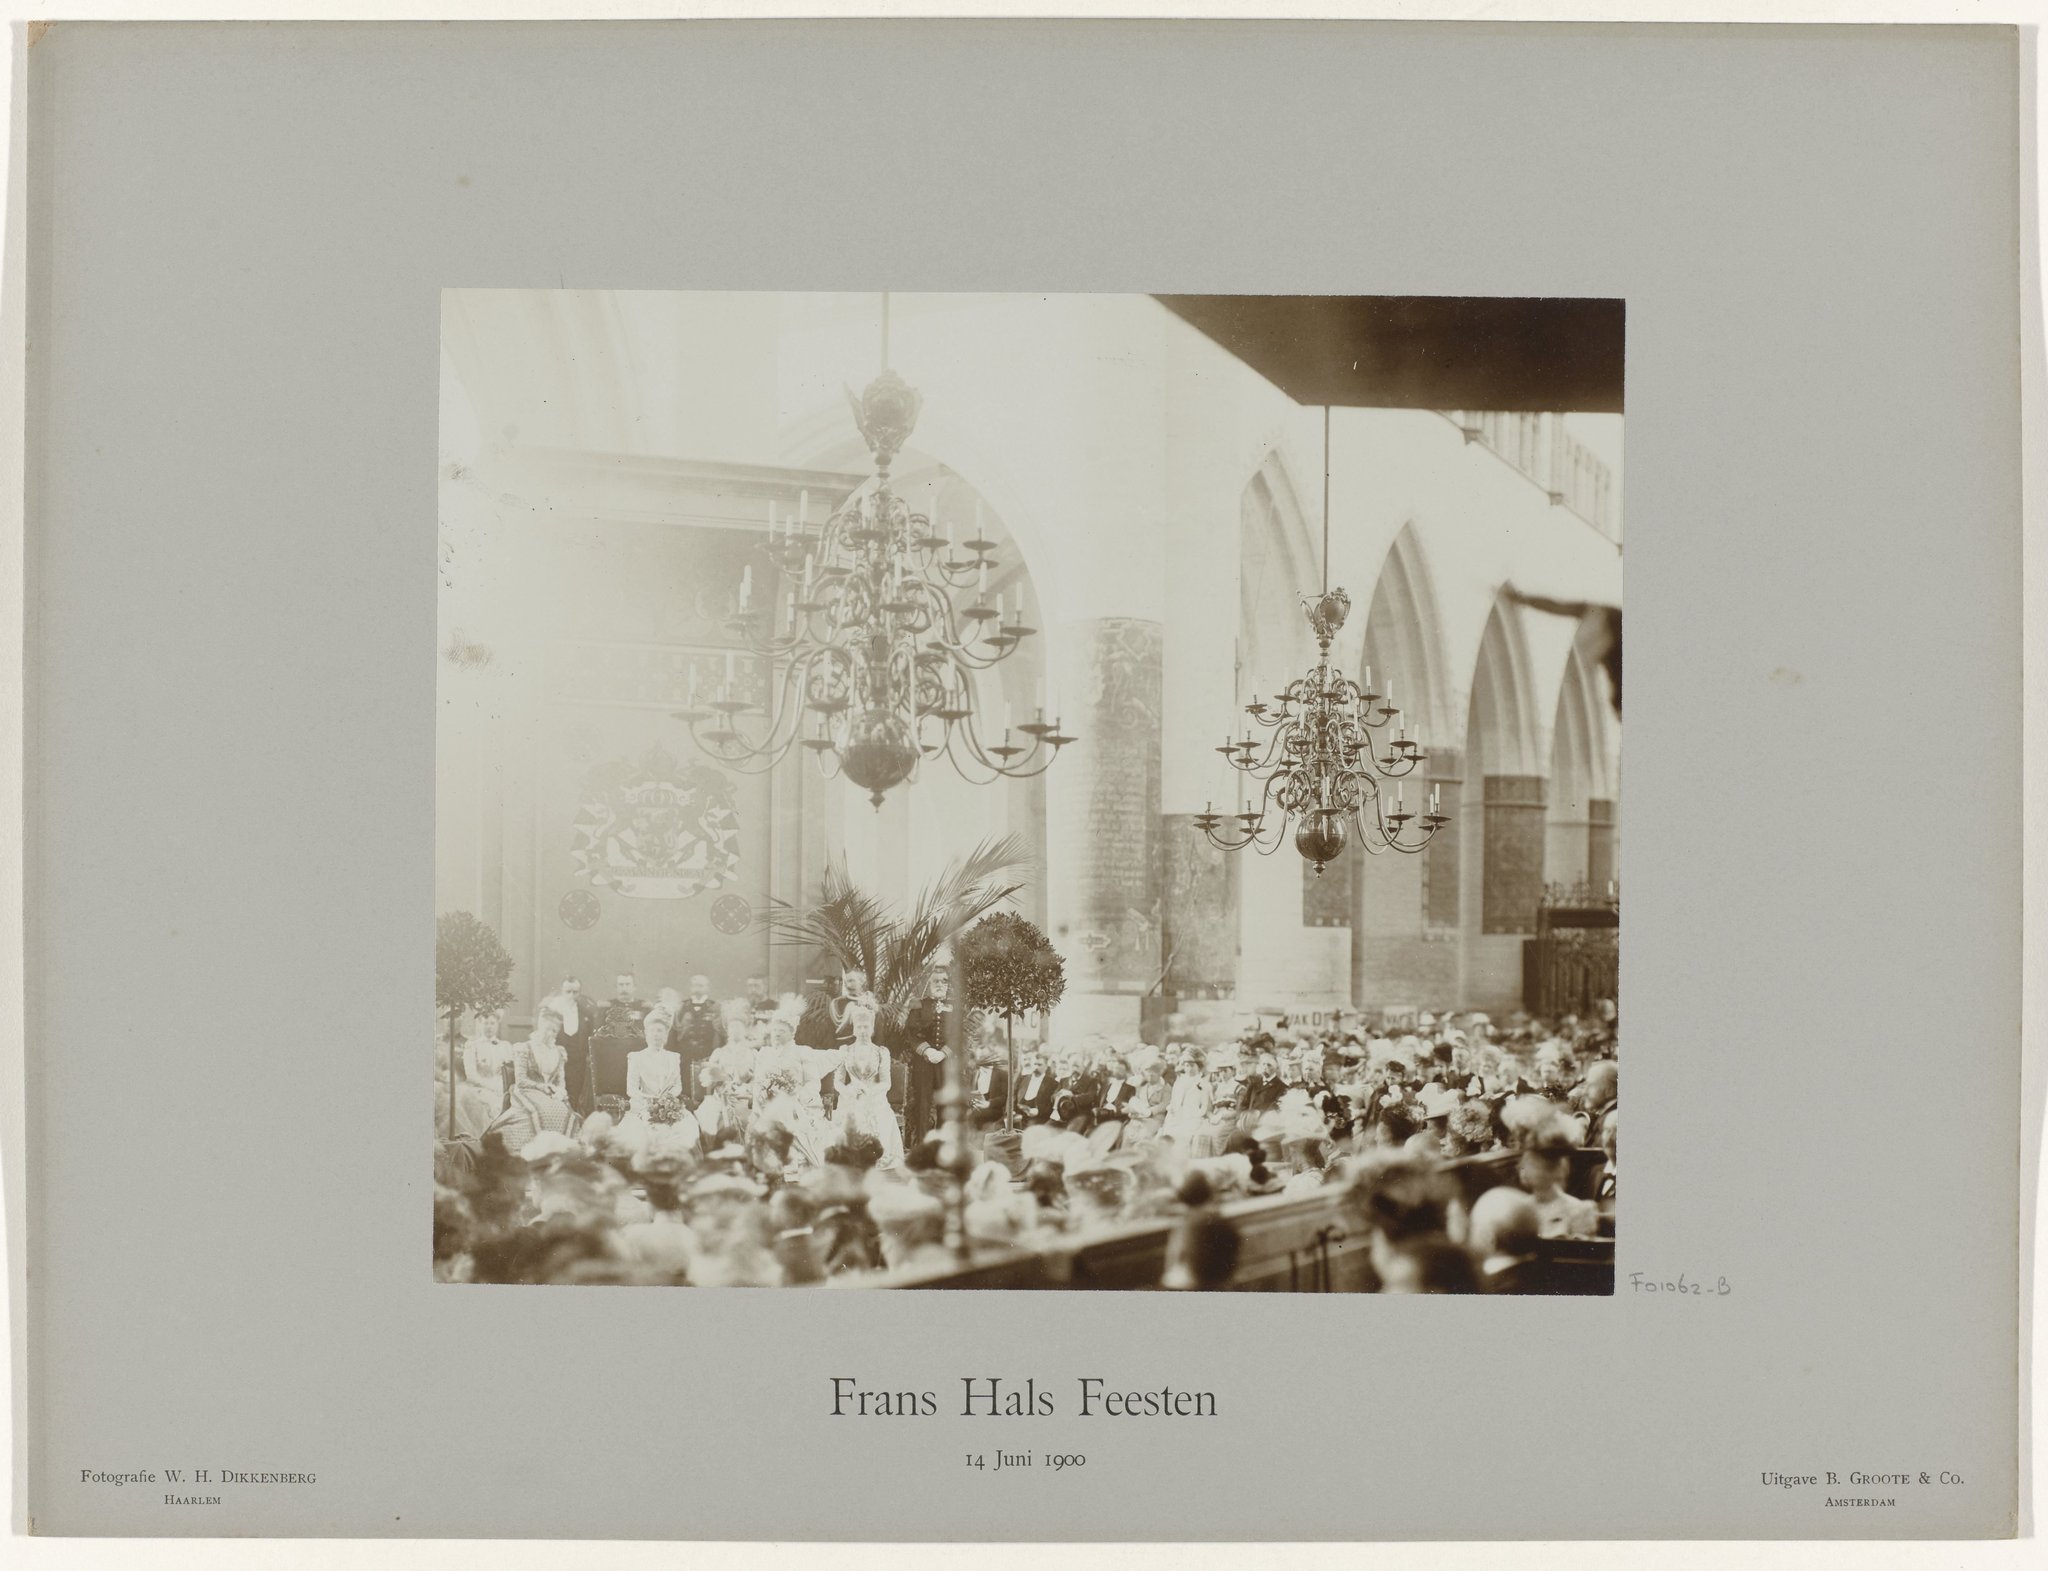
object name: photograph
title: Concert in aanwezigheid van Koningin Wilhelmina en Koningin-Moeder Emma in de Grote of Sint Bavo-kerk te Haarlem ter gelegenheid van de Frans Hals Feesten op 14 juni 1900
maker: willem hendrik dikkenberg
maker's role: fotograaf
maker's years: 1872-1946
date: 1900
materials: photographic support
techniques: collodion silver print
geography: haarlem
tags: print maker, wilhelmina of the netherlands, the hague, emma (queen consort of the netherlands), interior of church, public festivities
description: Onderdeel van Fotoalbum met opnames van de Frans Hals Feesten in Haarlem op 14 juni 1900.